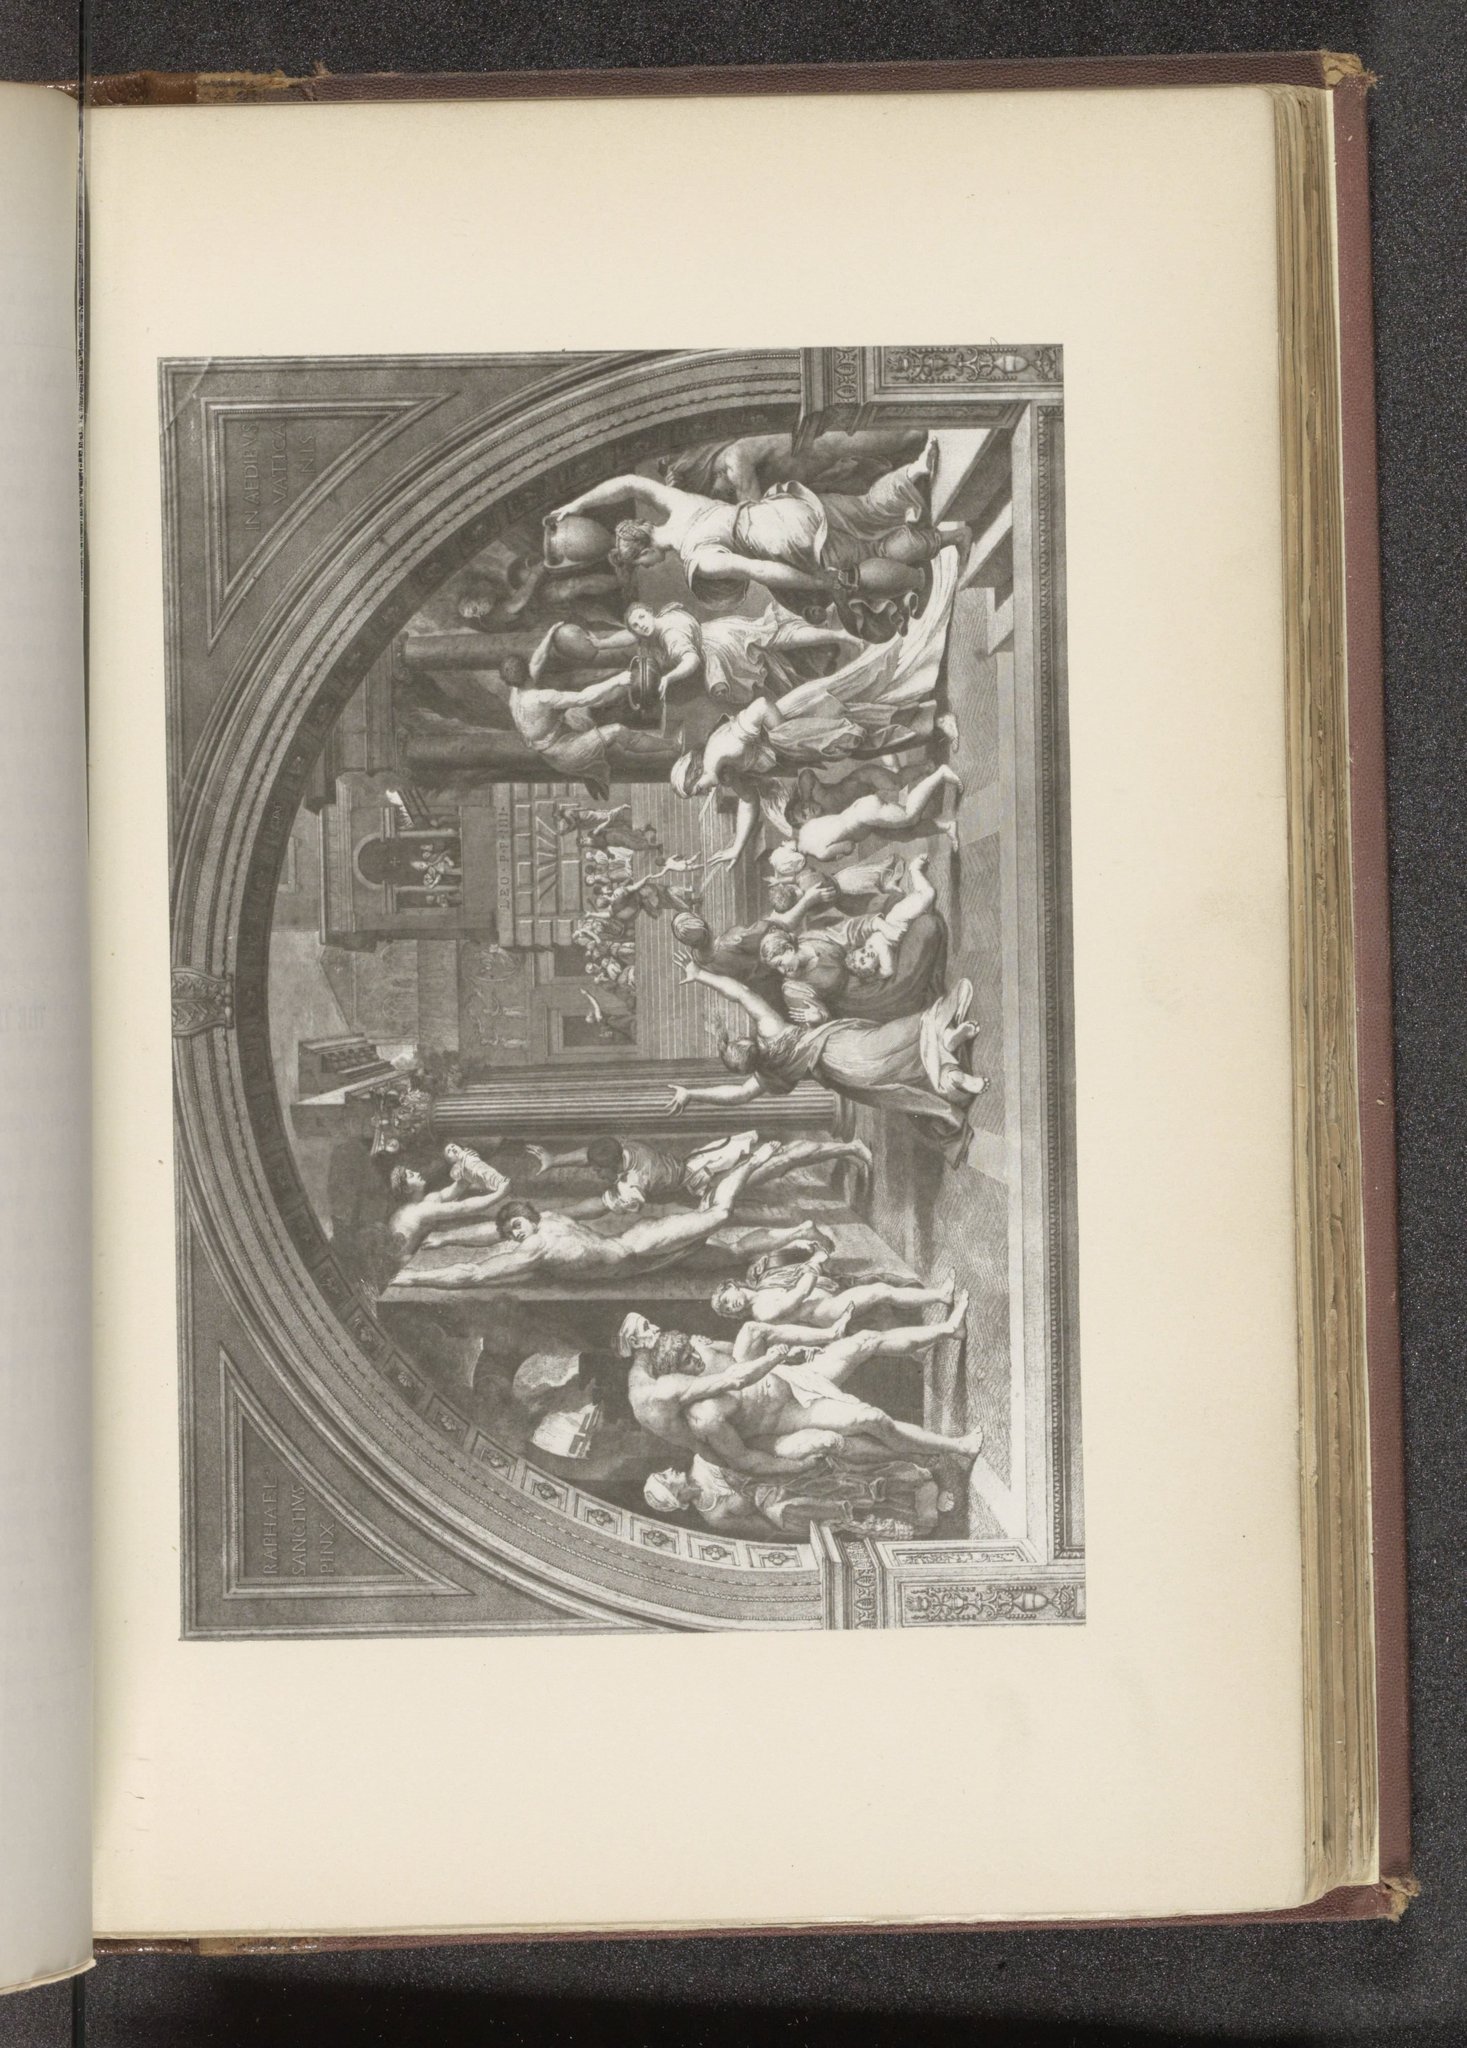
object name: reproduction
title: Fotoreproductie van het fresco Brand in Borgo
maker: Anonymous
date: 1872-1882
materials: paper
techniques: woodburytype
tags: open fire (in general)